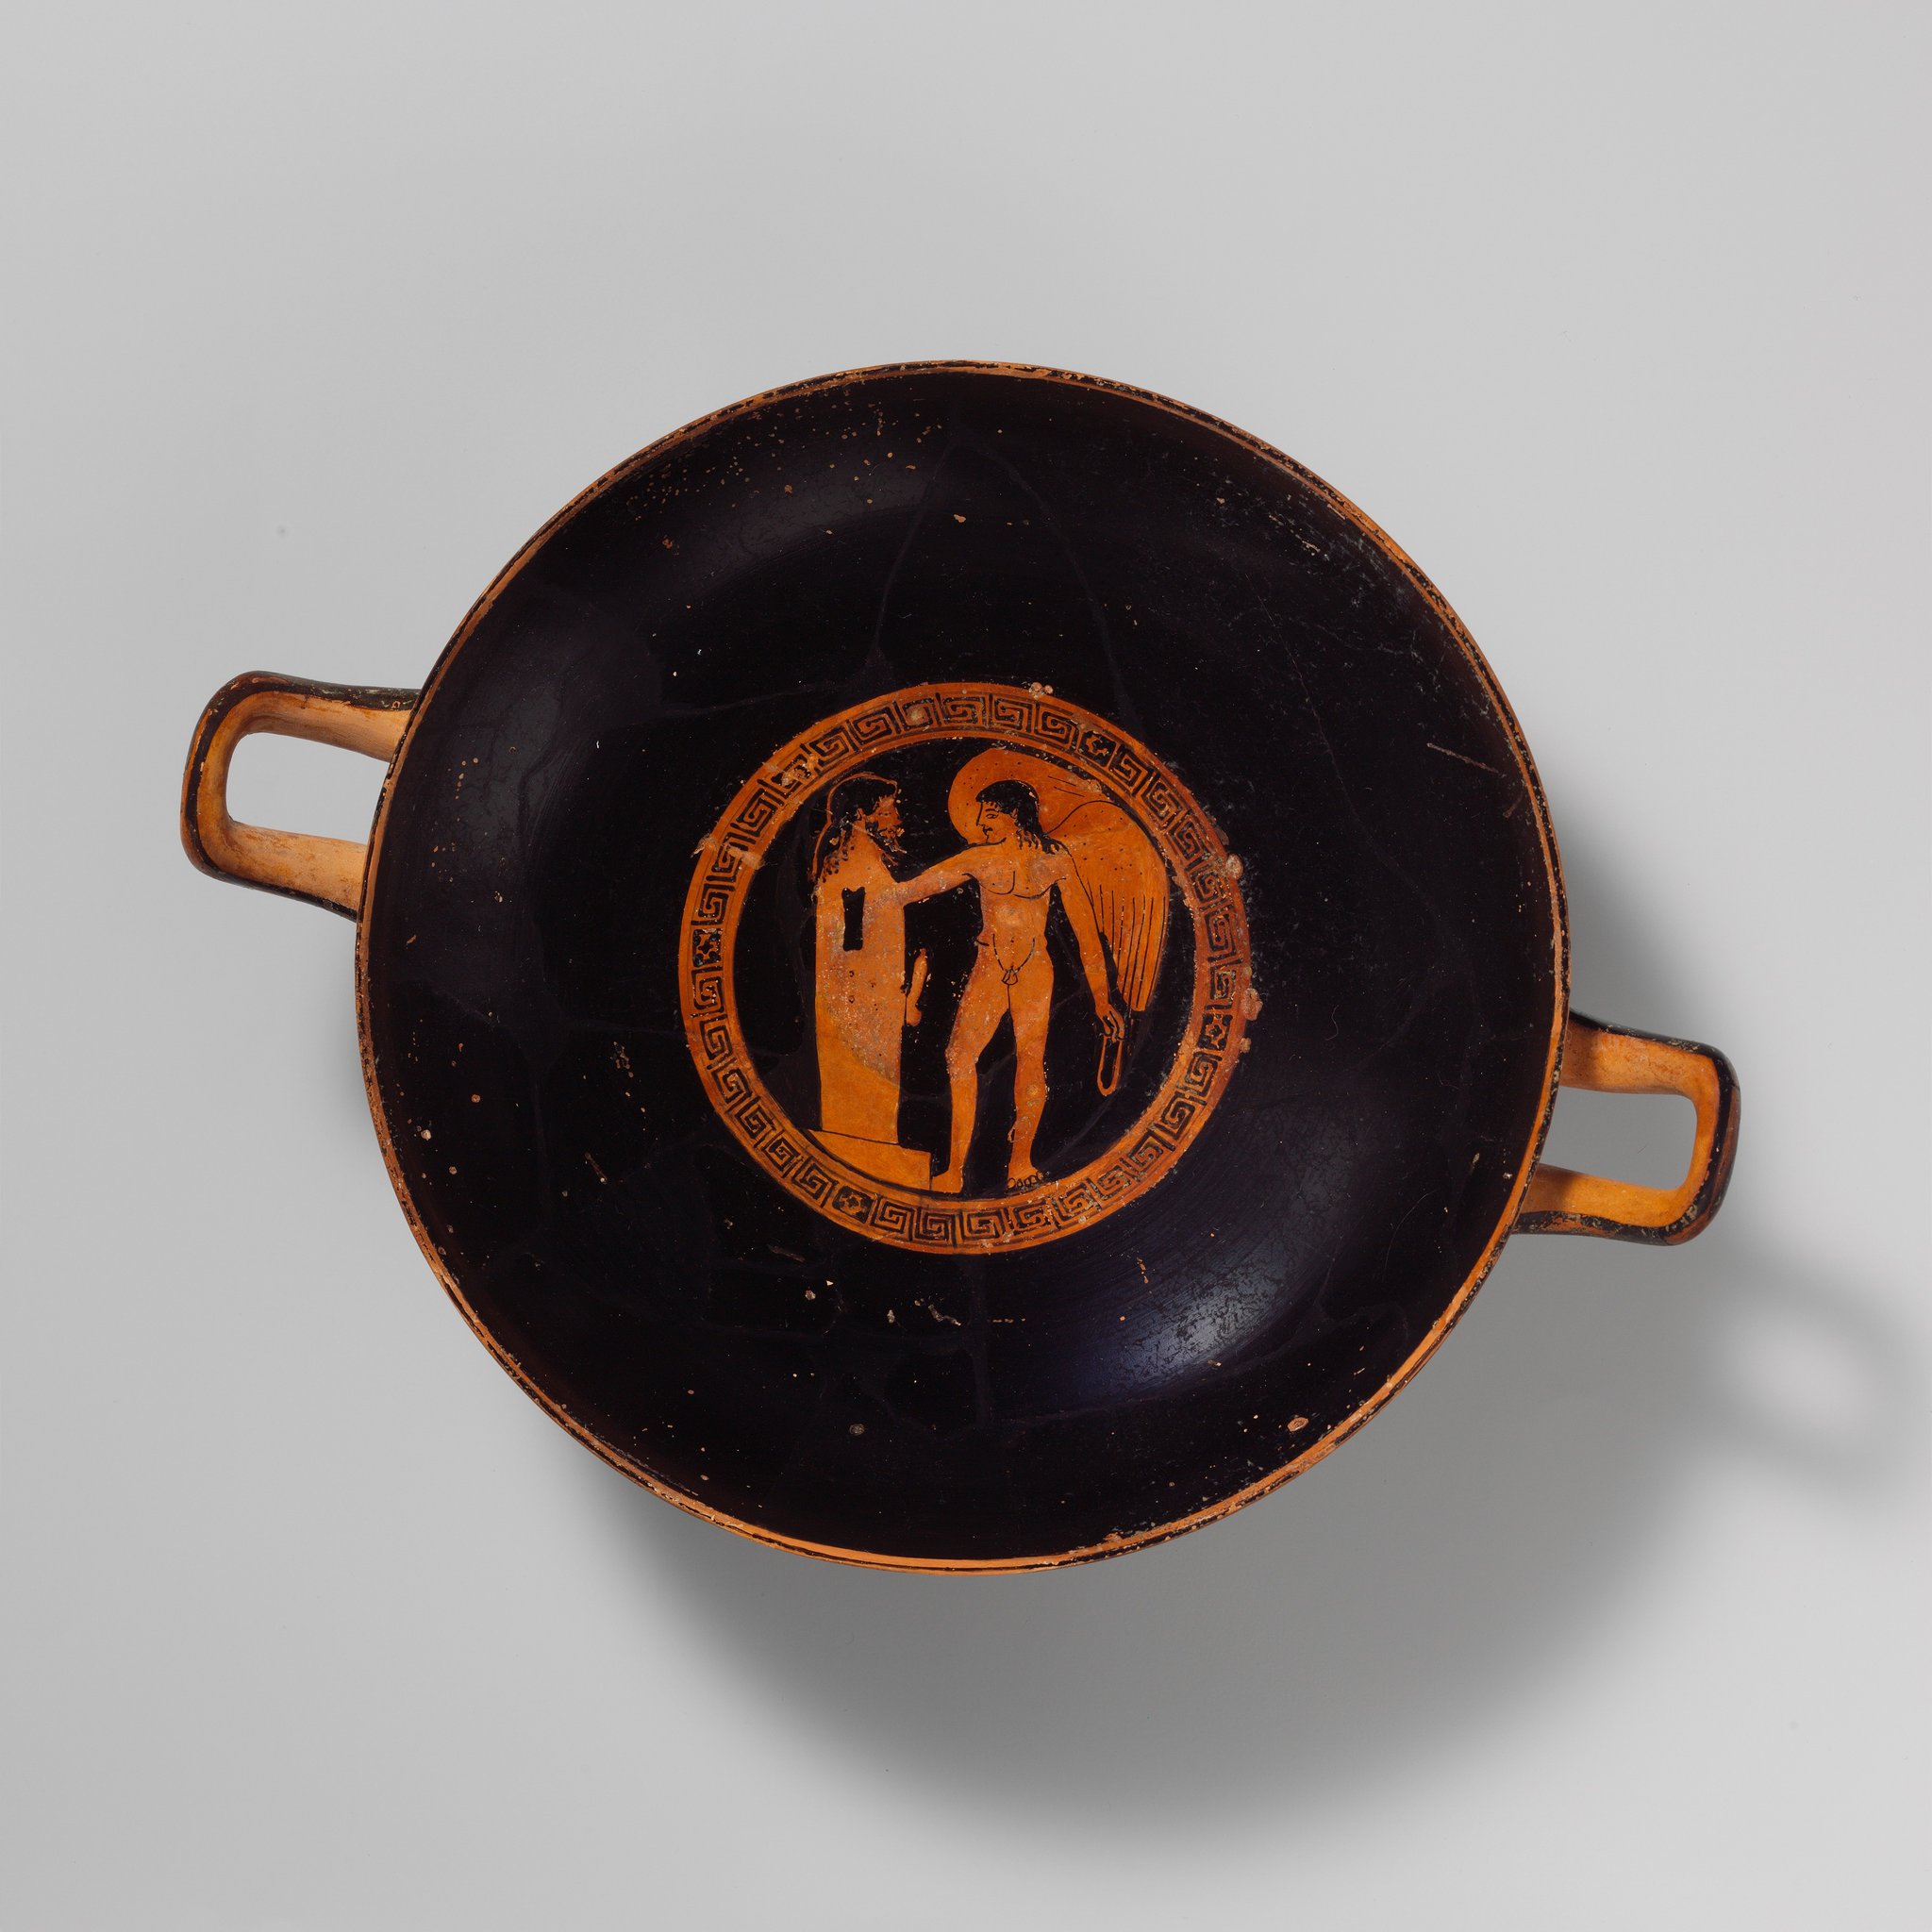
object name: kylix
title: Terracotta kylix (drinking cup)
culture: greek, attic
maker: painter of würzburg 487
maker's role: artist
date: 467-435 BCE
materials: terracotta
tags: eros